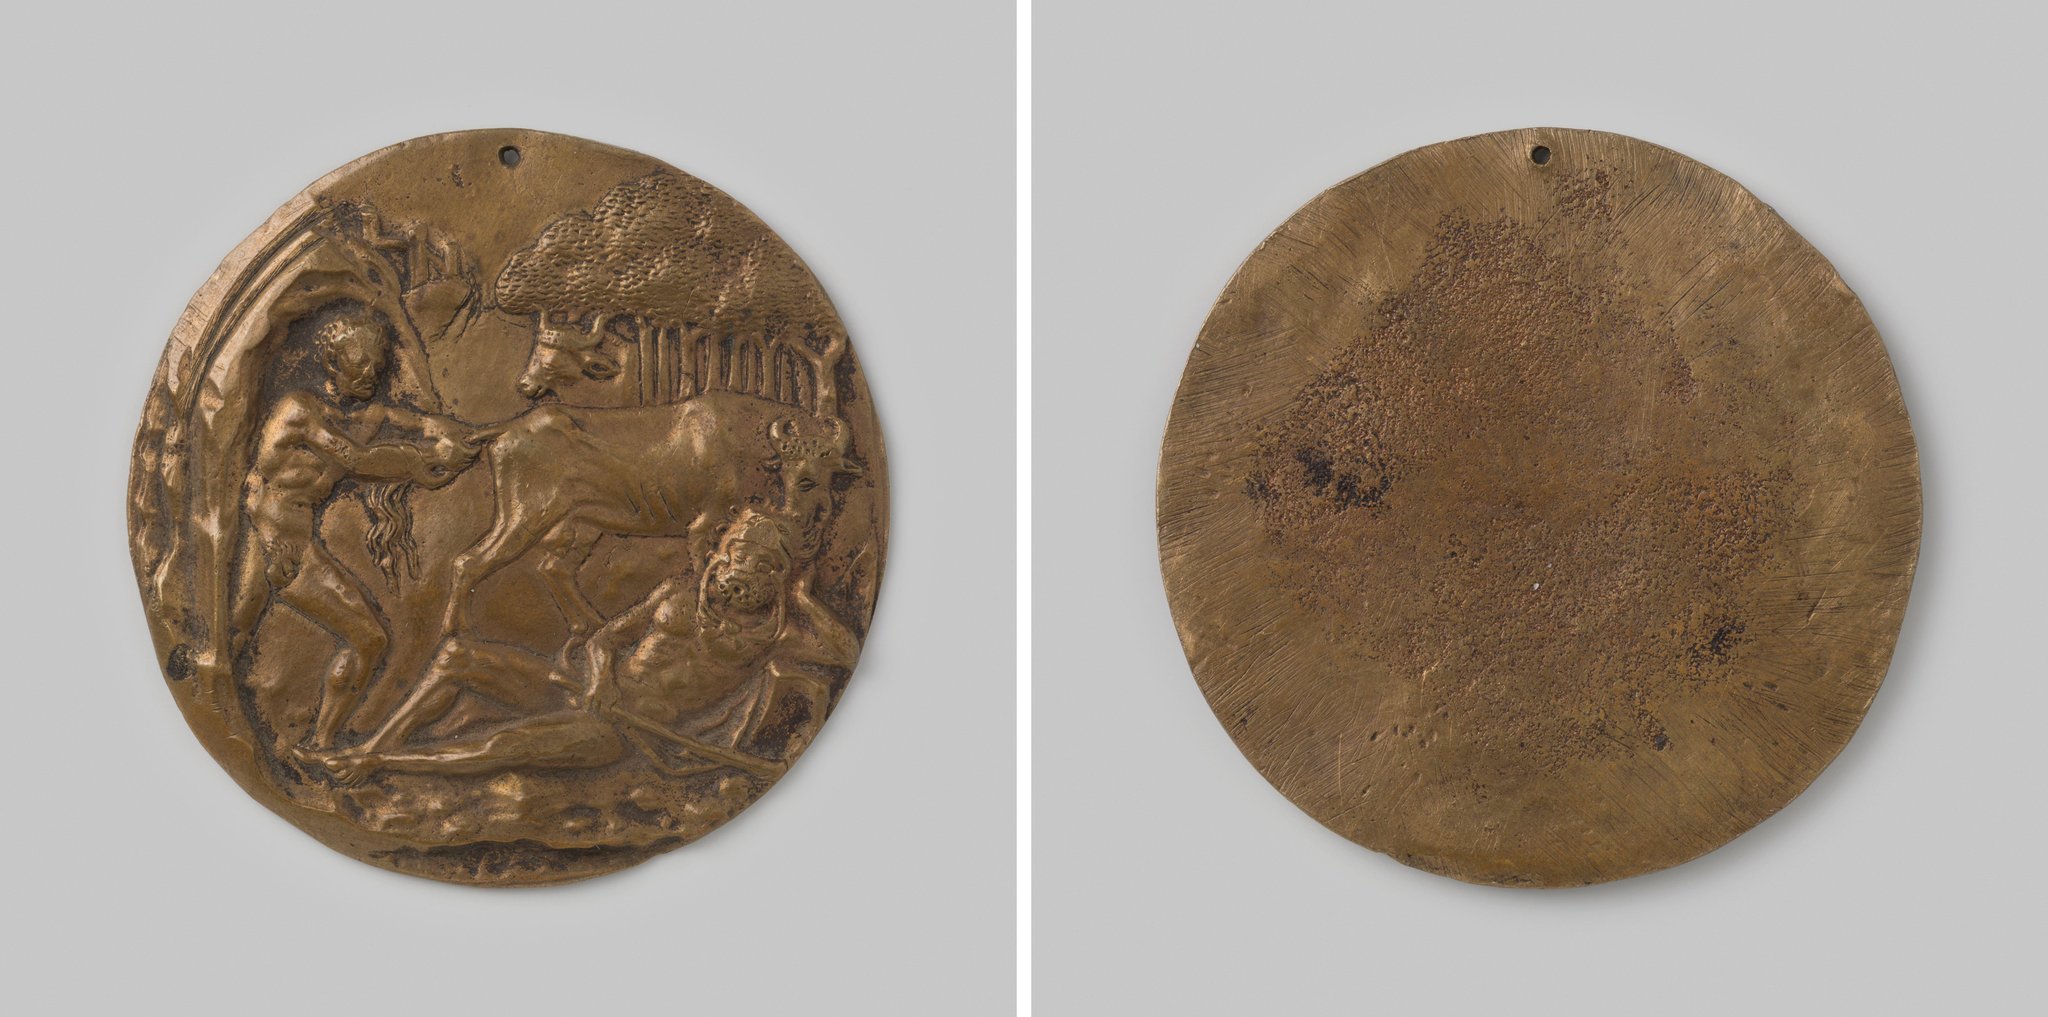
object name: history medal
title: Medaillon met Cacus en de slapende Hercules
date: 1600-1800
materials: brass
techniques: casting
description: Eenzijdig messing medaillon met draagat, voorstellende Cacus die een koe aan de staart van de slapende Hercules wegtrekt naar zijn grot (Tiende Werk).